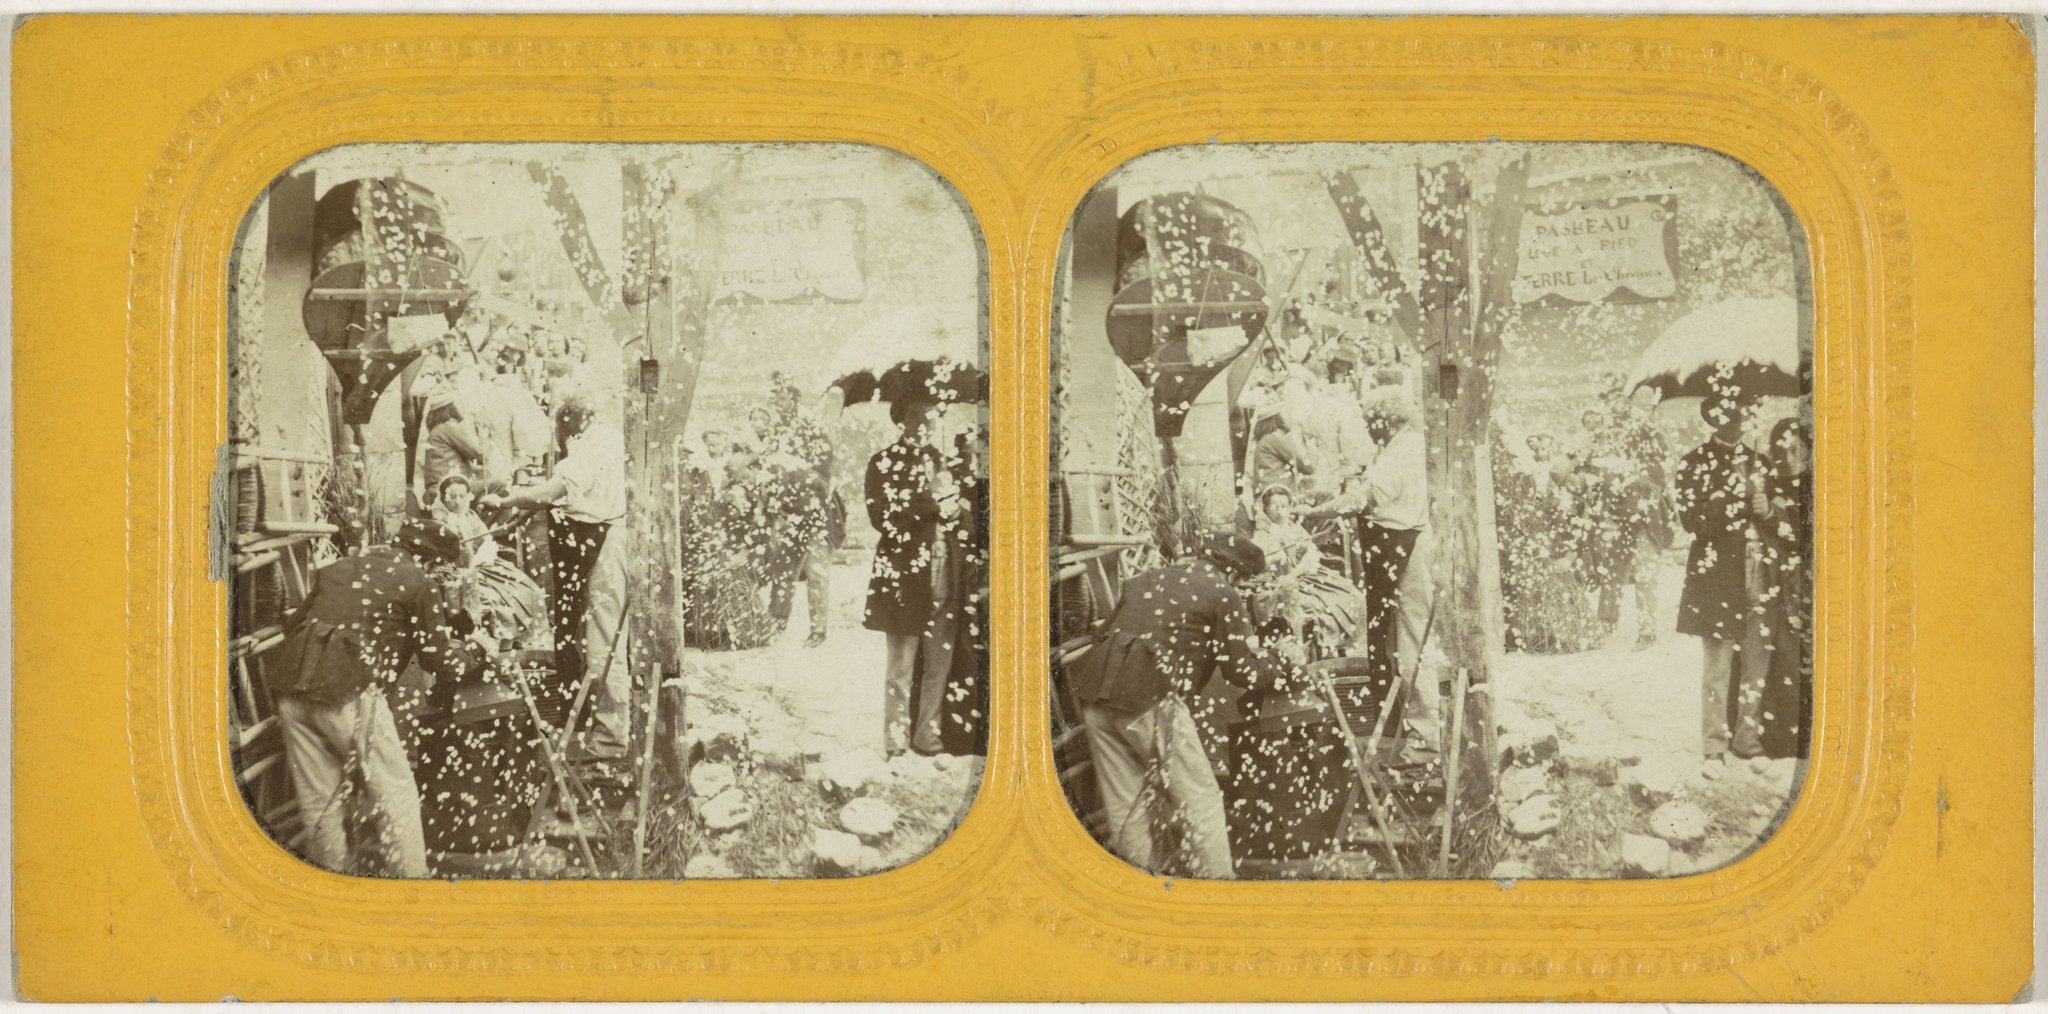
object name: photograph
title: Genrescène: wandelaars in de sneeuw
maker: Anonymous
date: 1865-1885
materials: cardboard, paper, photographic support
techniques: albumen print